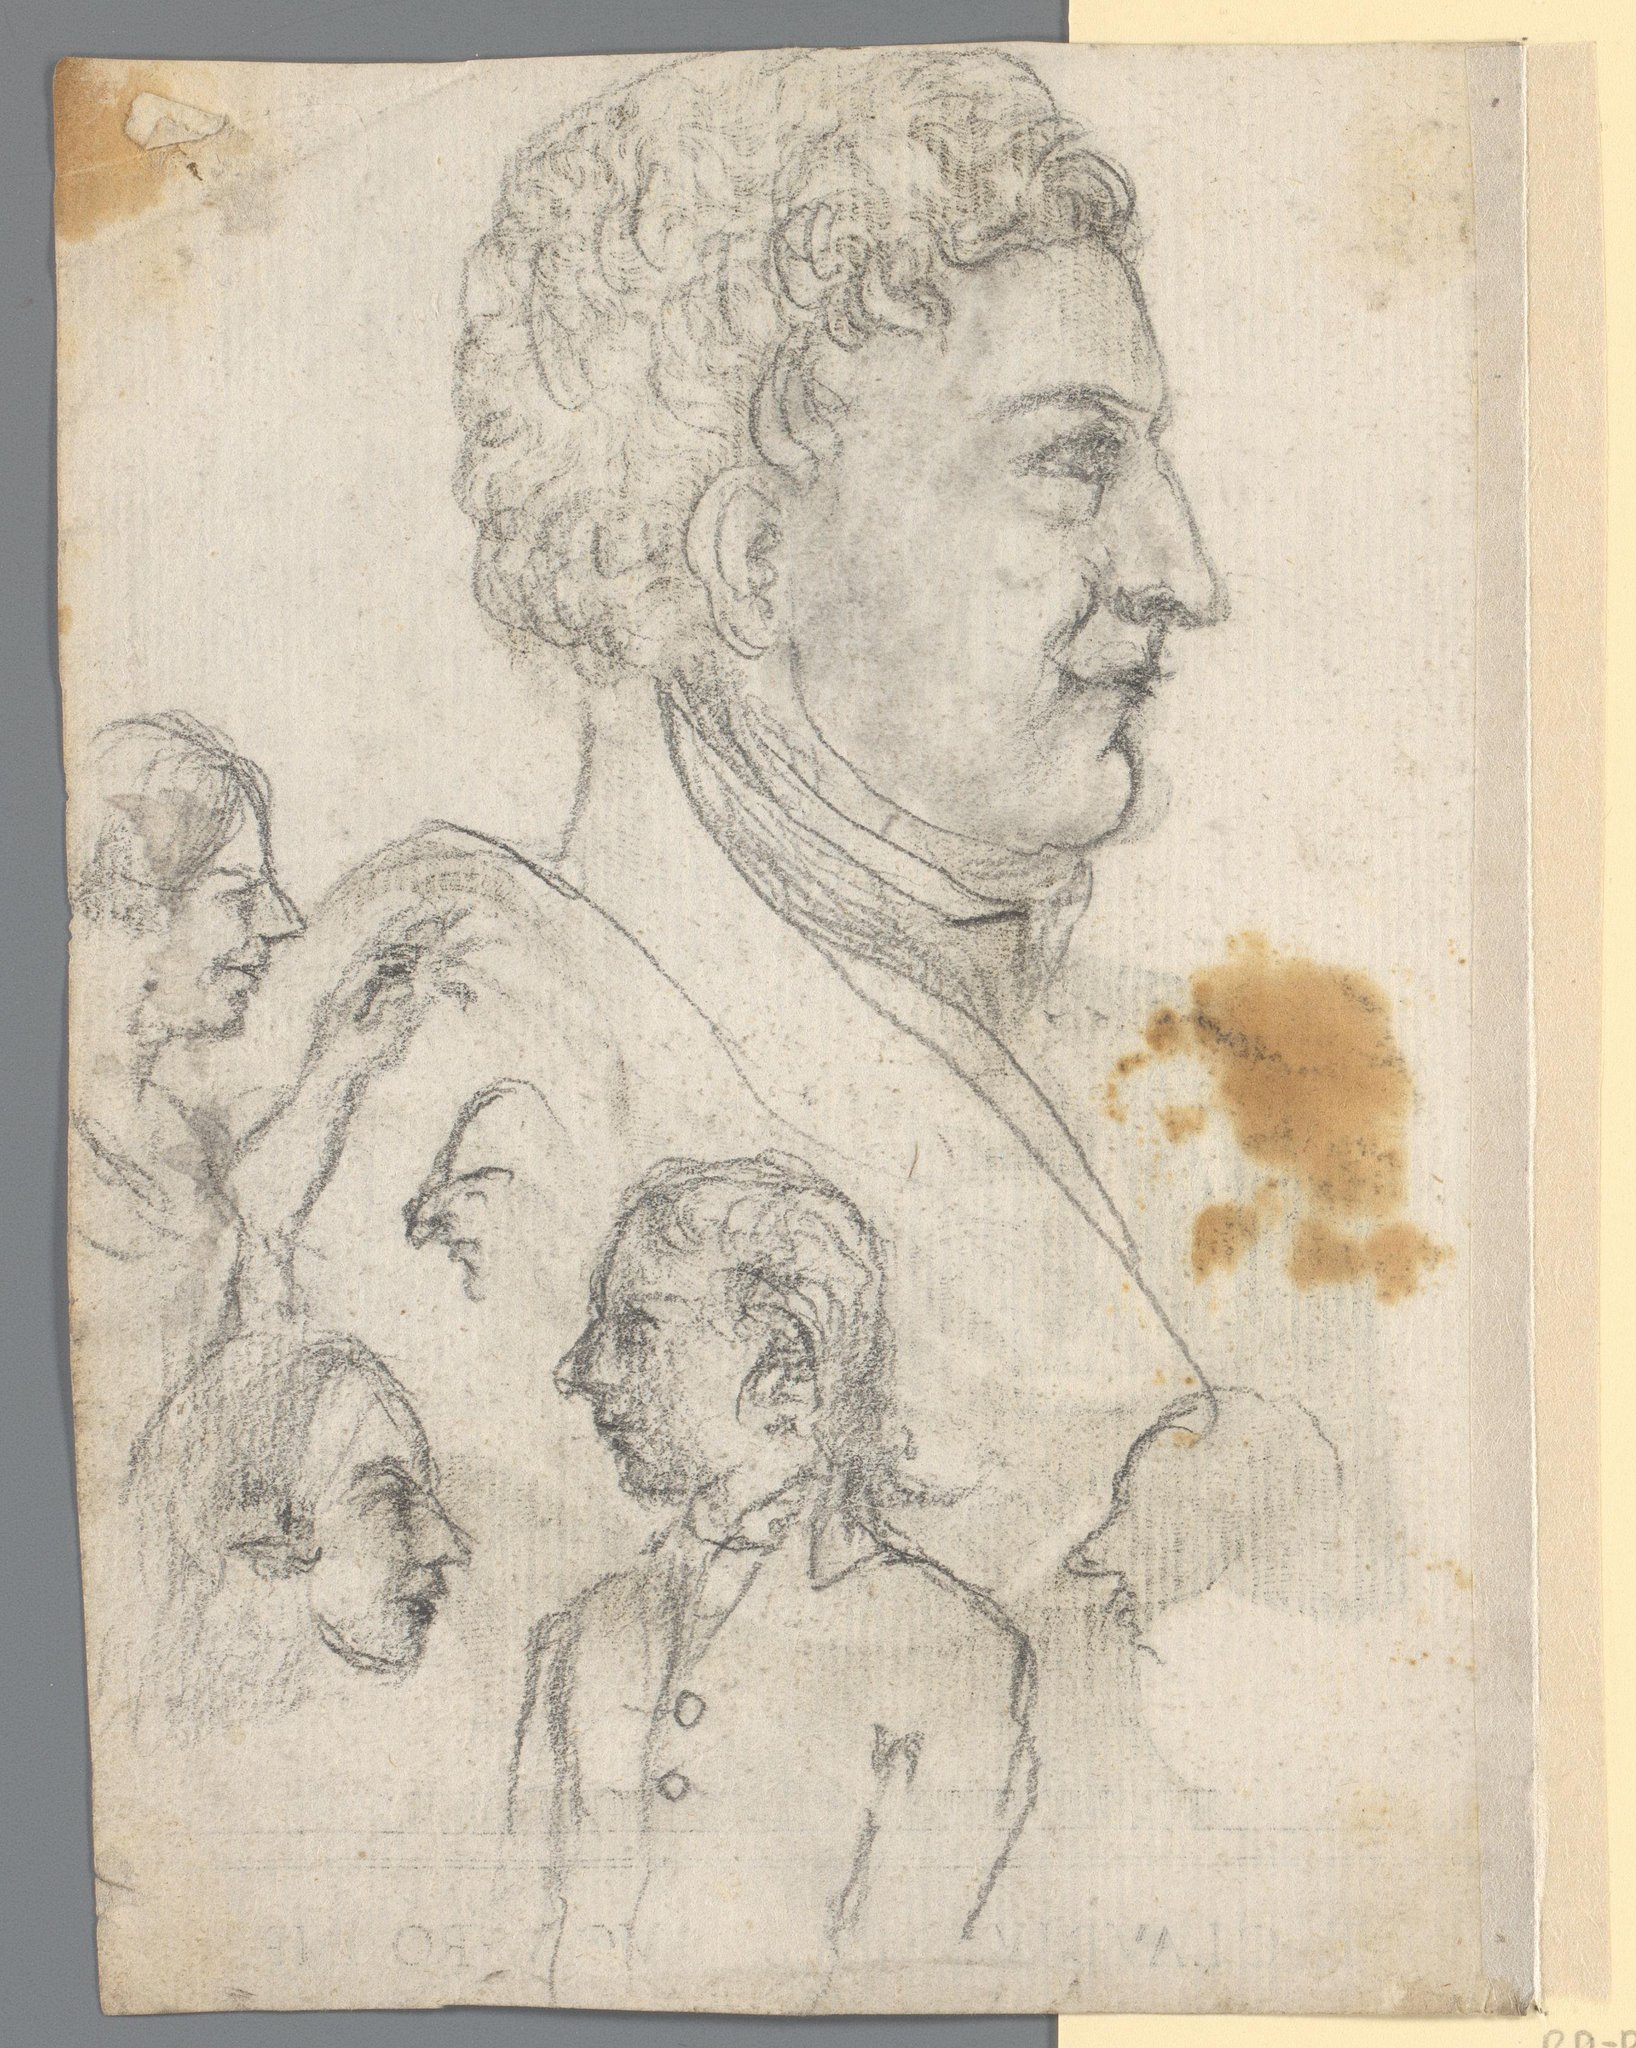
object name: drawing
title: Studie van hoofden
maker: Anonymous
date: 1750-1820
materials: paper, pencil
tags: head (human)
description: Studie van zes hoofden van mannen en vrouwen van opzij gezien. Twee profielen zijn niet uitgewerkt.